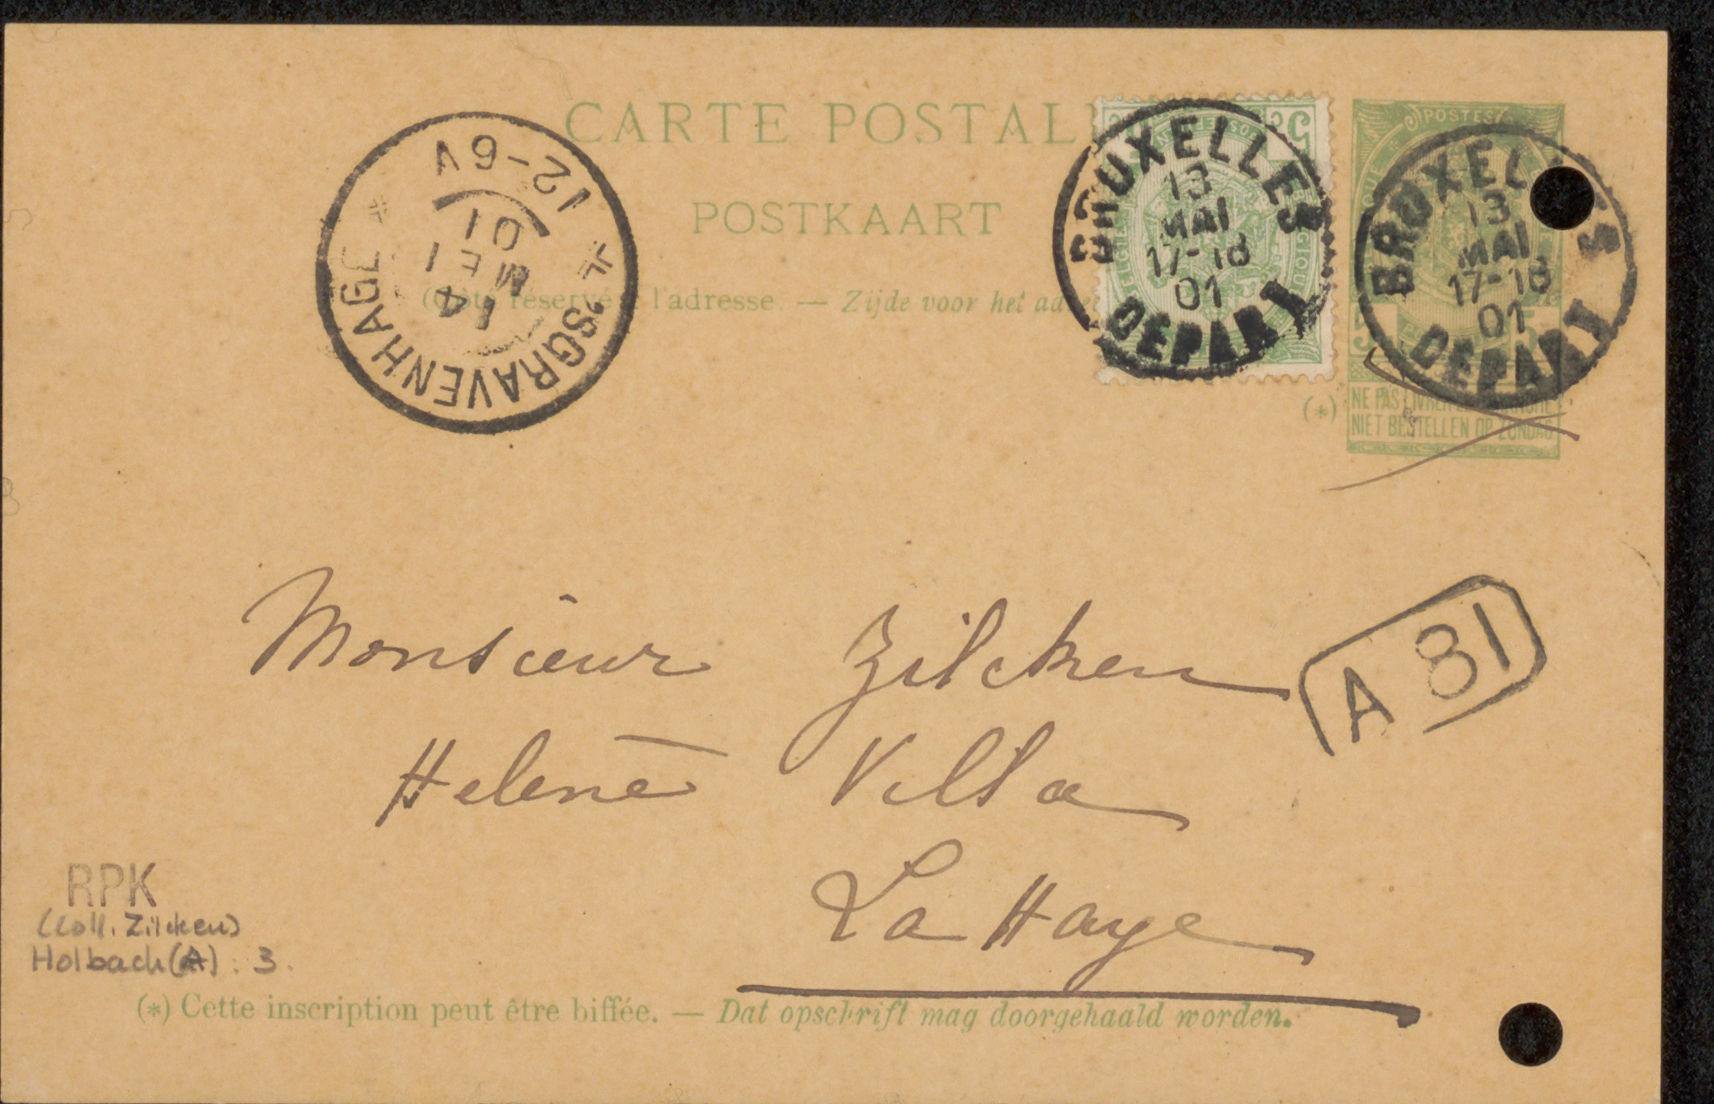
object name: postcard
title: Briefkaart aan Philip Zilcken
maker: alice holbach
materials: cardboard, ink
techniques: pen, writing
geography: brussels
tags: the hague, painter, draughtsman, philip zilcken, temporary exhibition, 'salon'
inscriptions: collector's mark: ‘RPK’